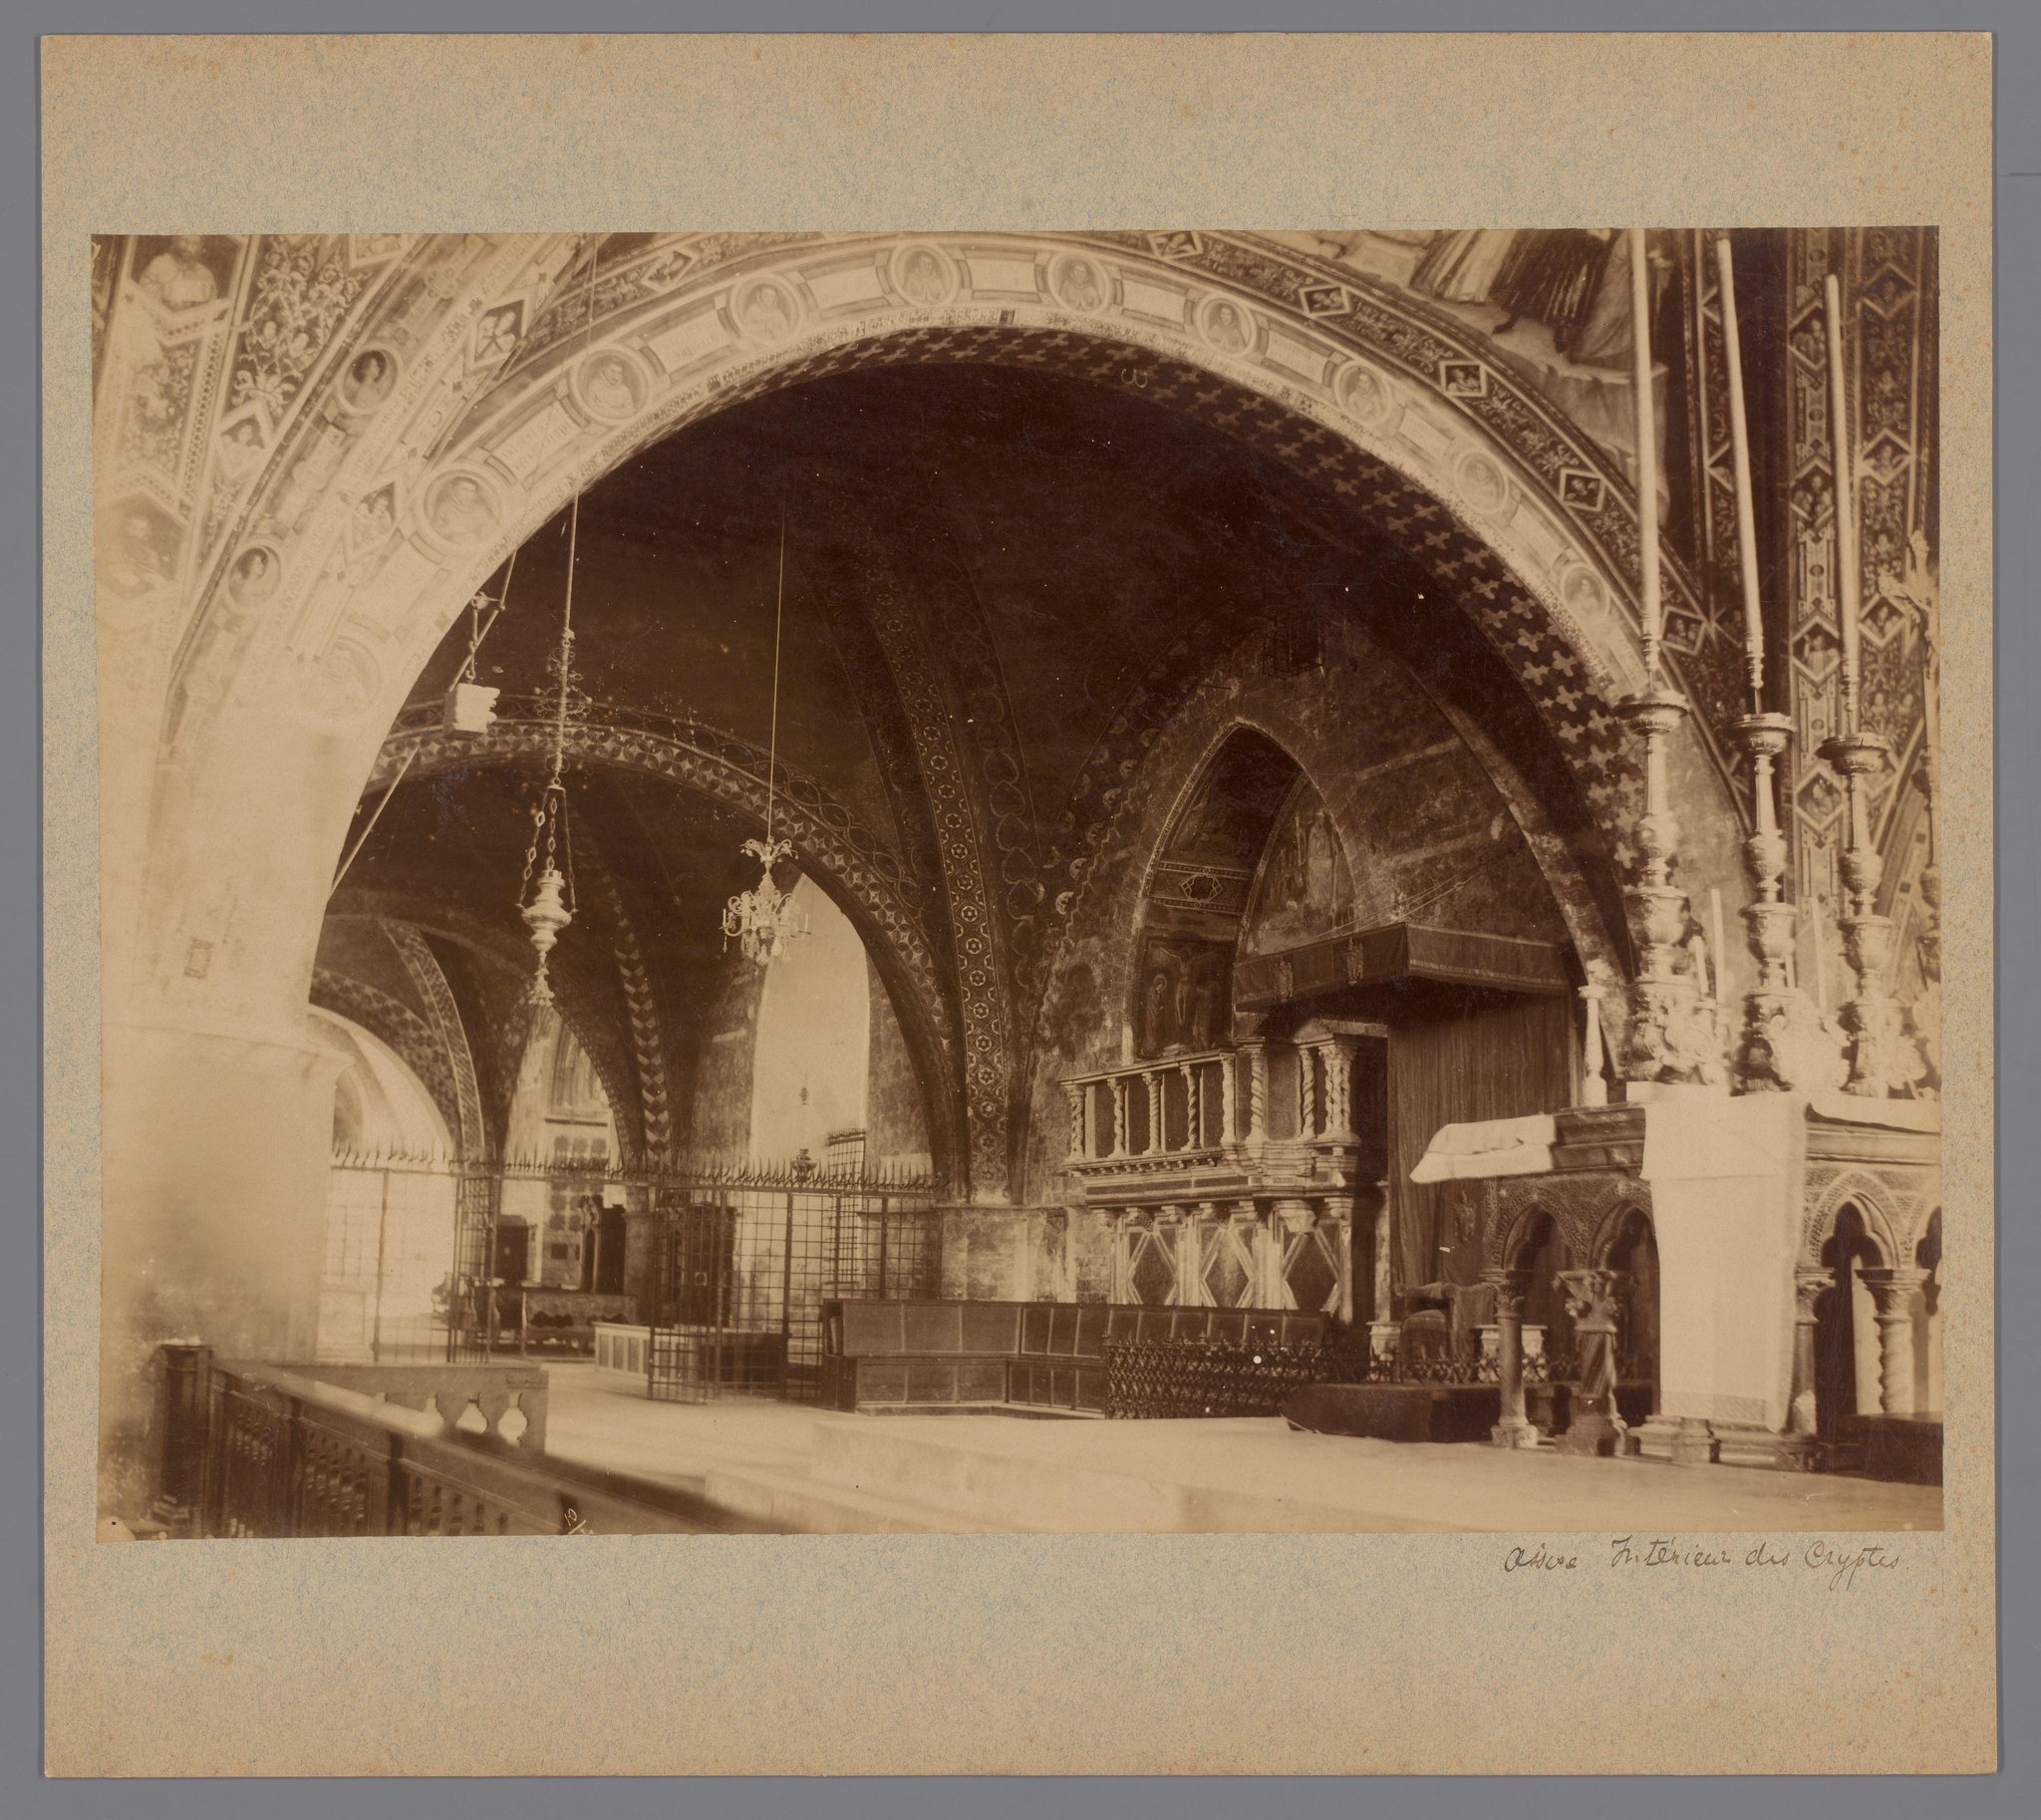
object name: photograph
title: Interieur van de crypte van een kerk in Assisi, Italië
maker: Anonymous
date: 1870-1900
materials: cardboard, paper, photographic support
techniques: albumen print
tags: assisi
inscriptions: inscription: ‘Assise Interieur des Cryptes’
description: Interieur van de crypte van een kerk in Assisi, Italië.